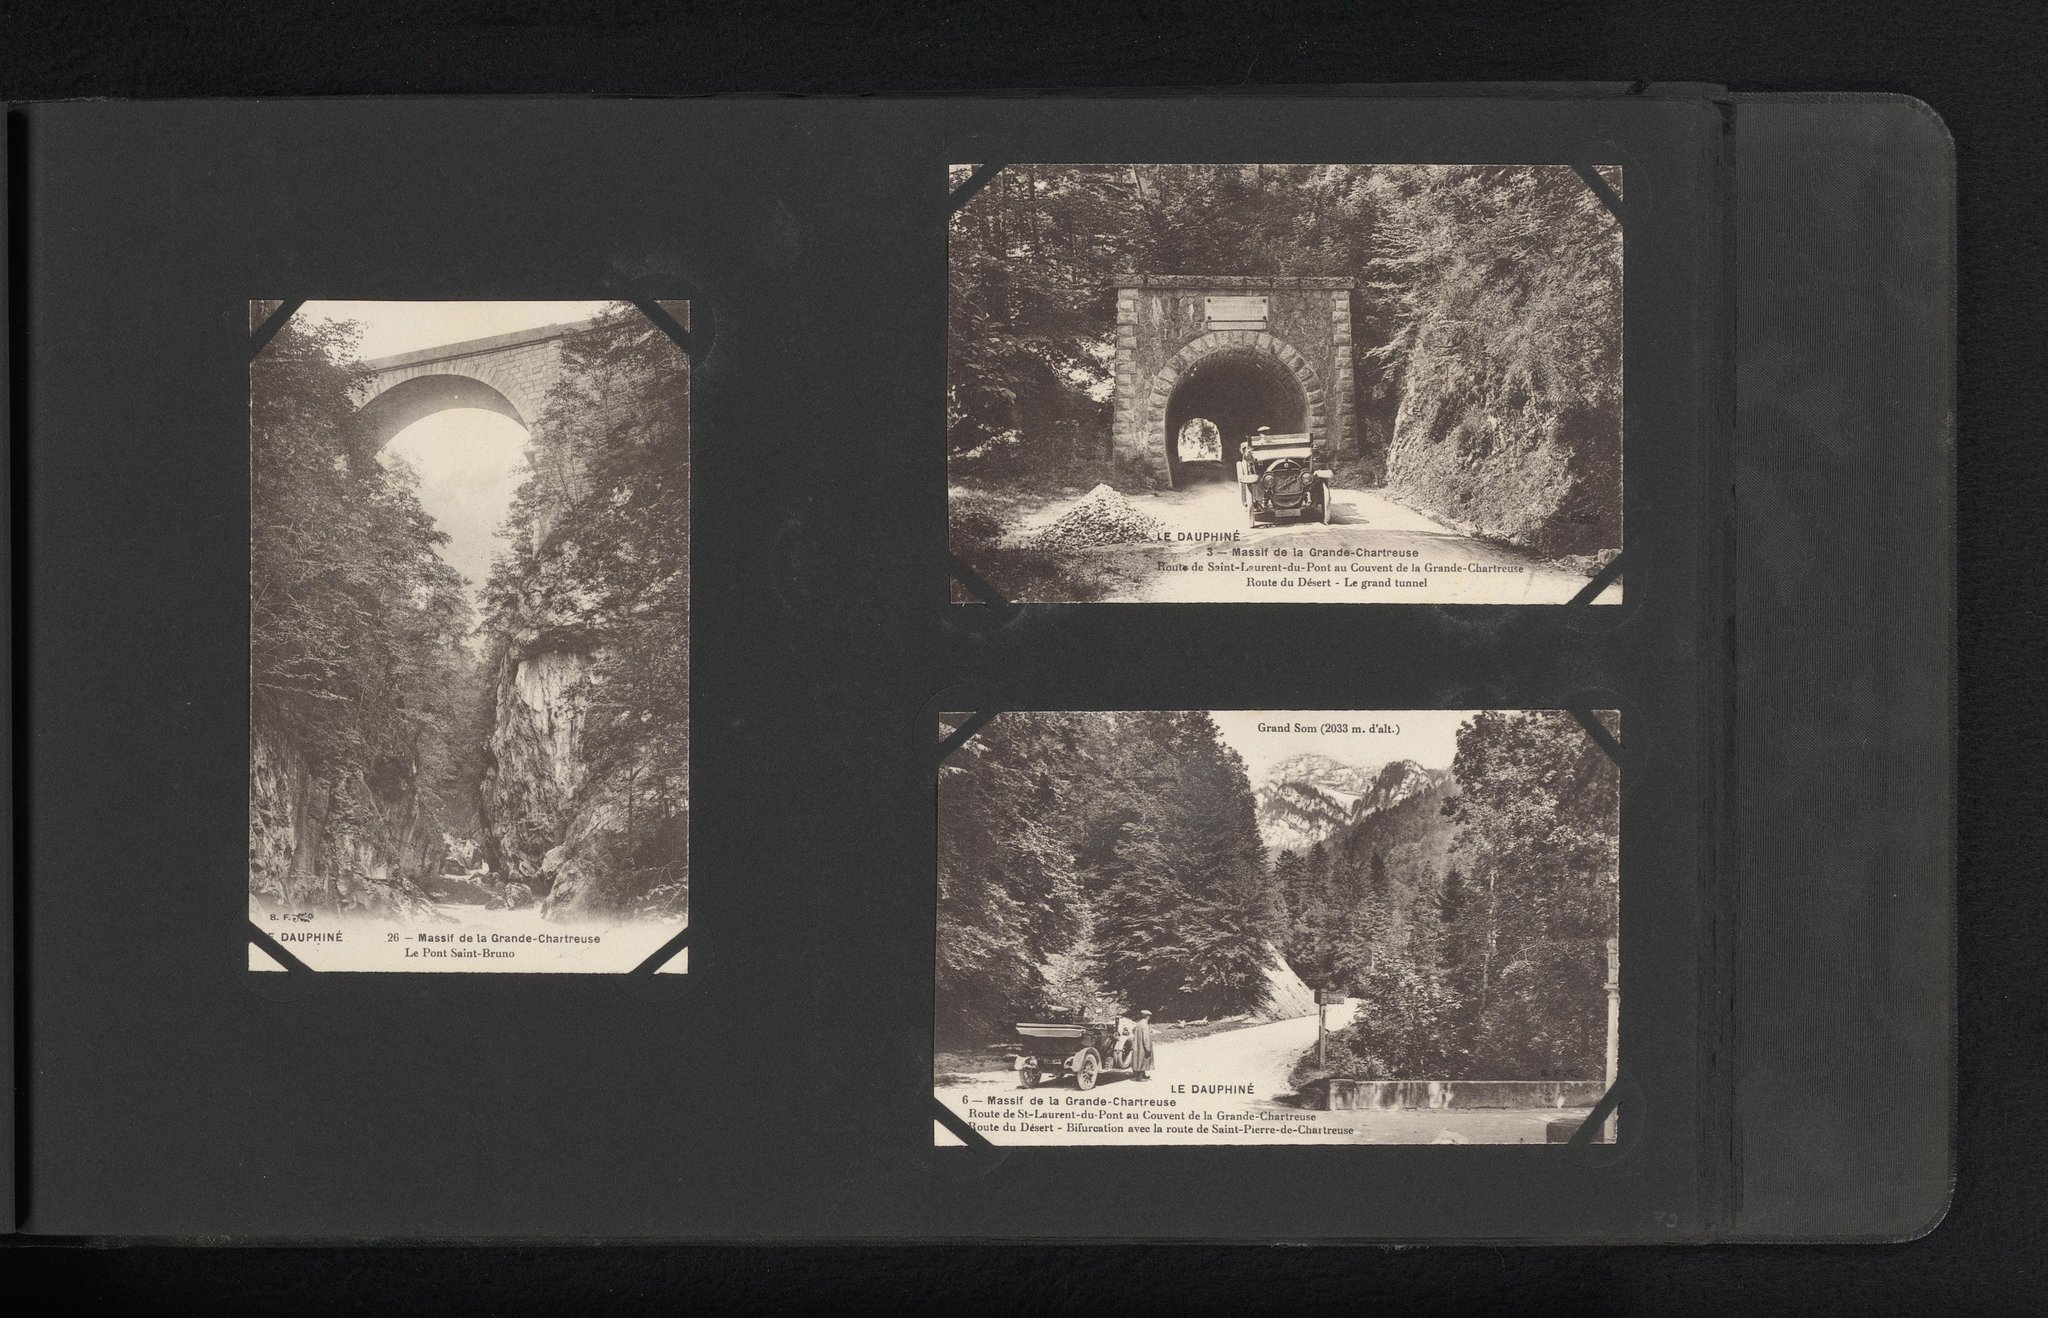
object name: ansichtkaart, prentbriefkaart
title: Drie fotomechanische prentbriefkaarten van wegen in het Massif de la Chartreuse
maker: Anonymous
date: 1908-1929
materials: cardboard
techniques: photograph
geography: paris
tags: automobile, mountains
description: Deze prenten maken deel uit van een album.